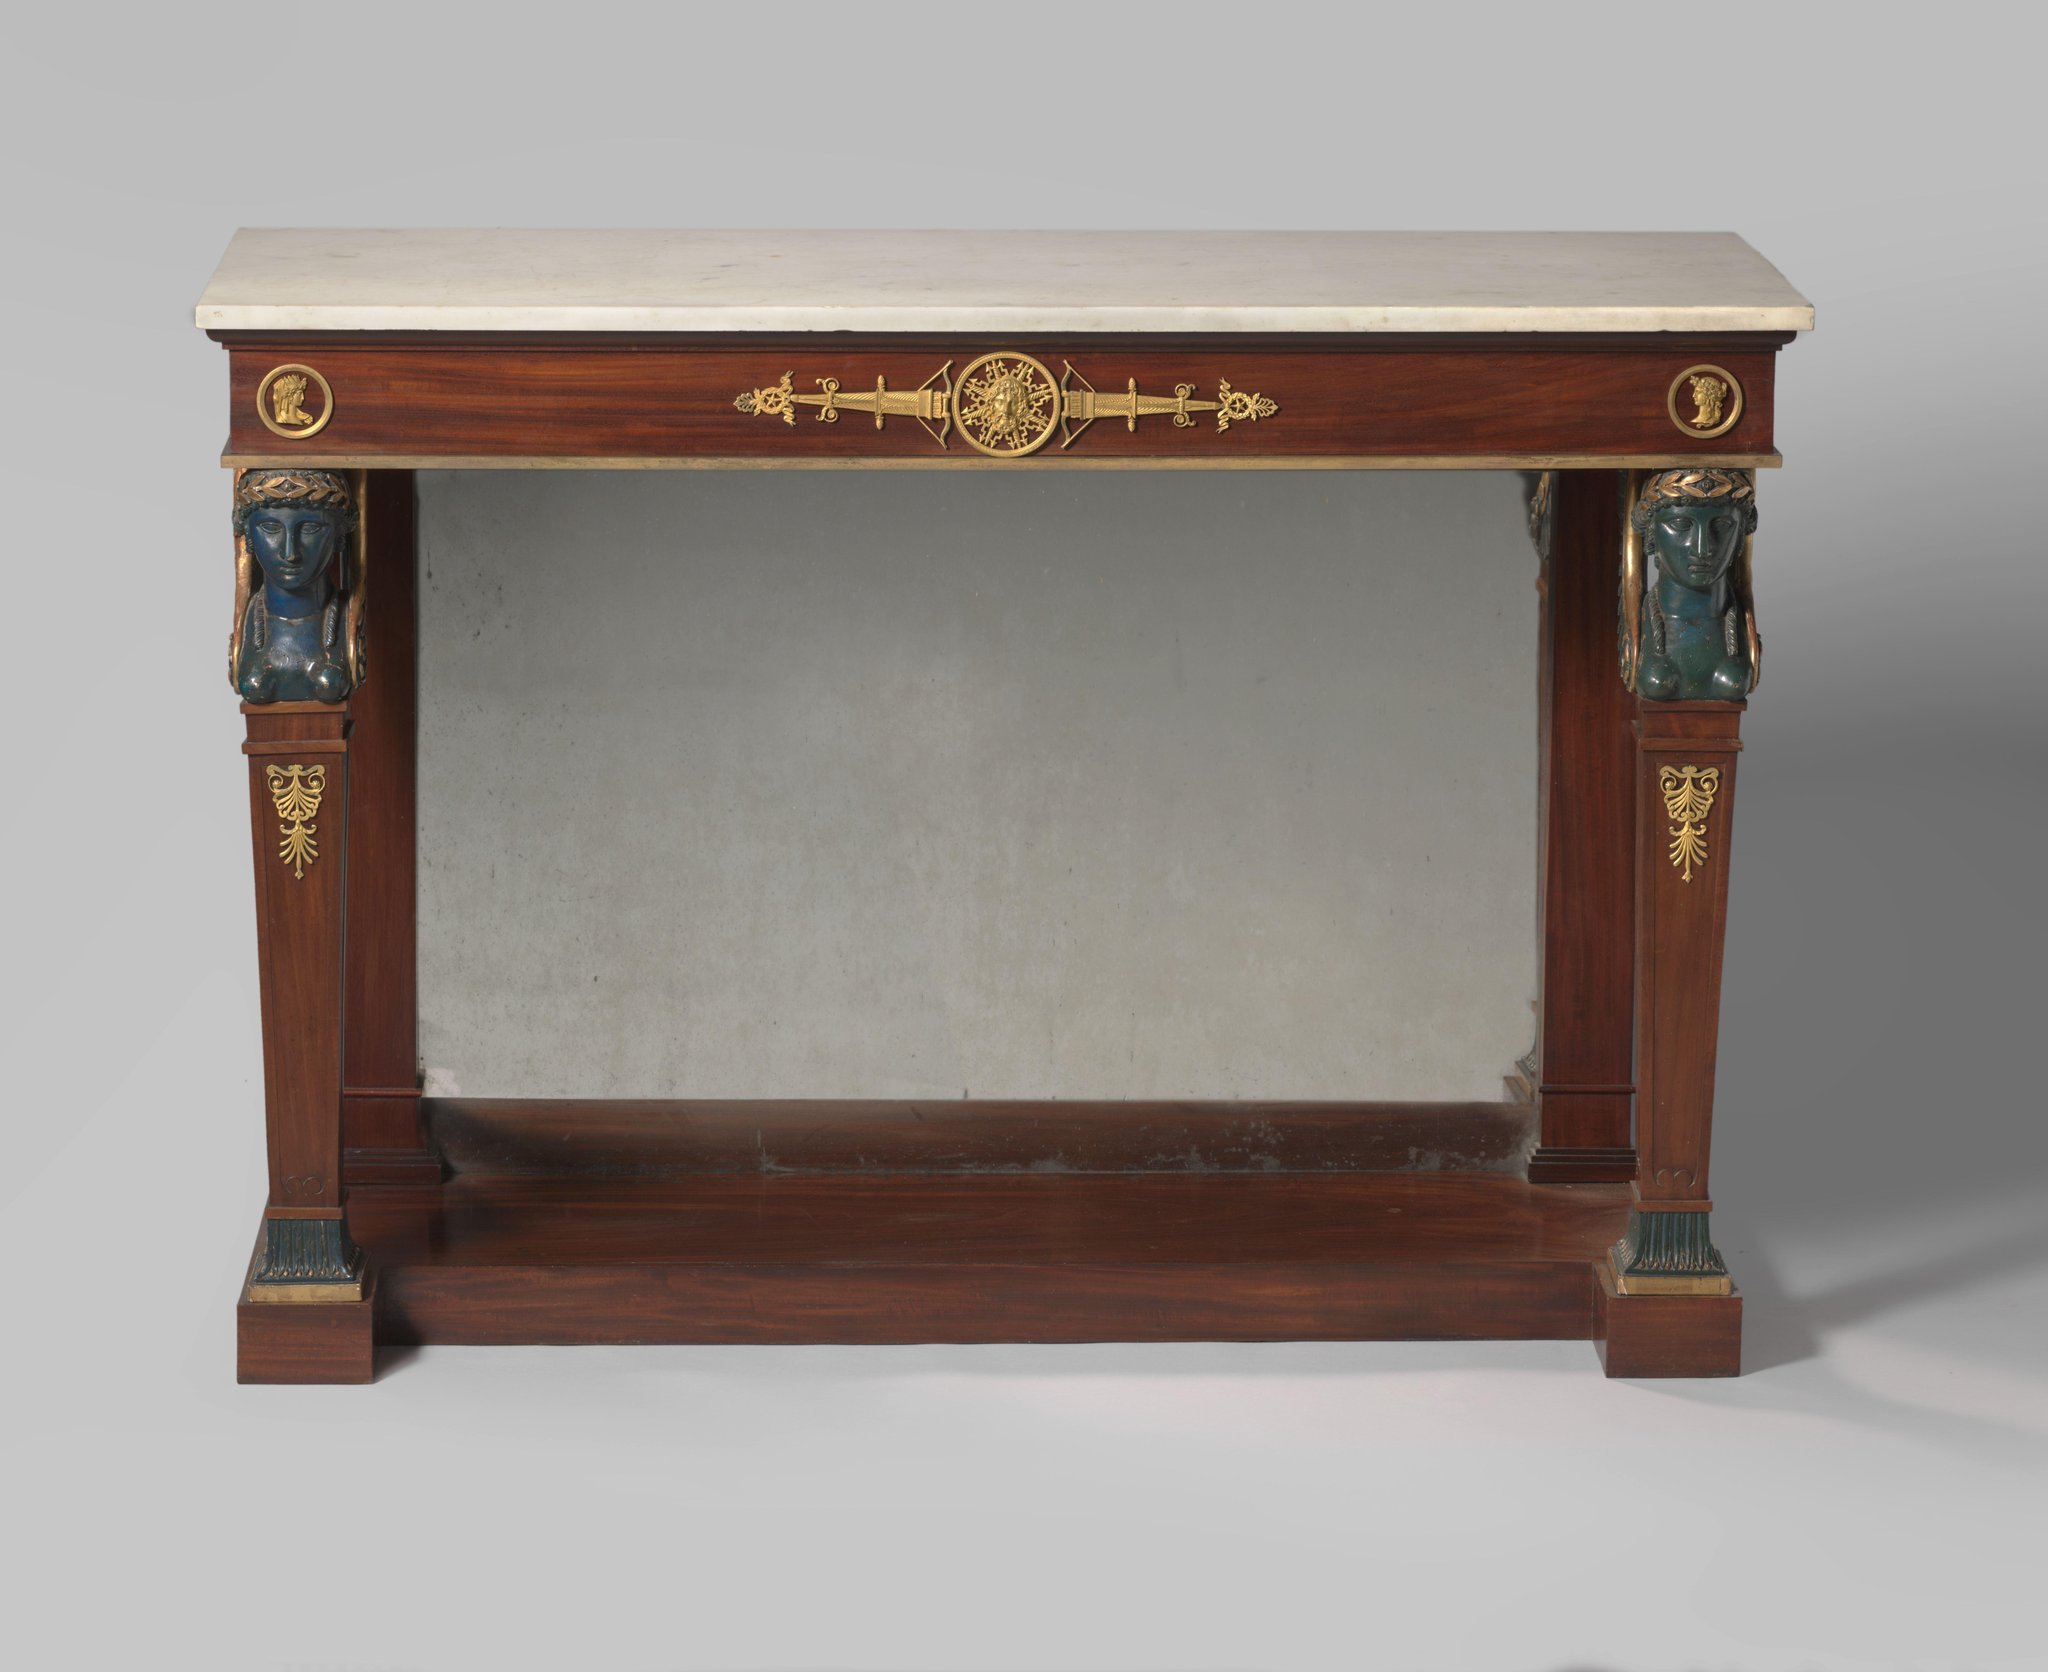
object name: furniture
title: Wandtafel met marmeren blad en poten in de vorm van gevleugelde kariatiden met roofdierpoten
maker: e. muller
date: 1810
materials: amalgam, brass, glass, wood, marble, paint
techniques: gilding, polychromy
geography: the hague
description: Side-table. Mahogany and other woods, partly gilded. The Hague, c. 1810, attributed to Eduard Muller.